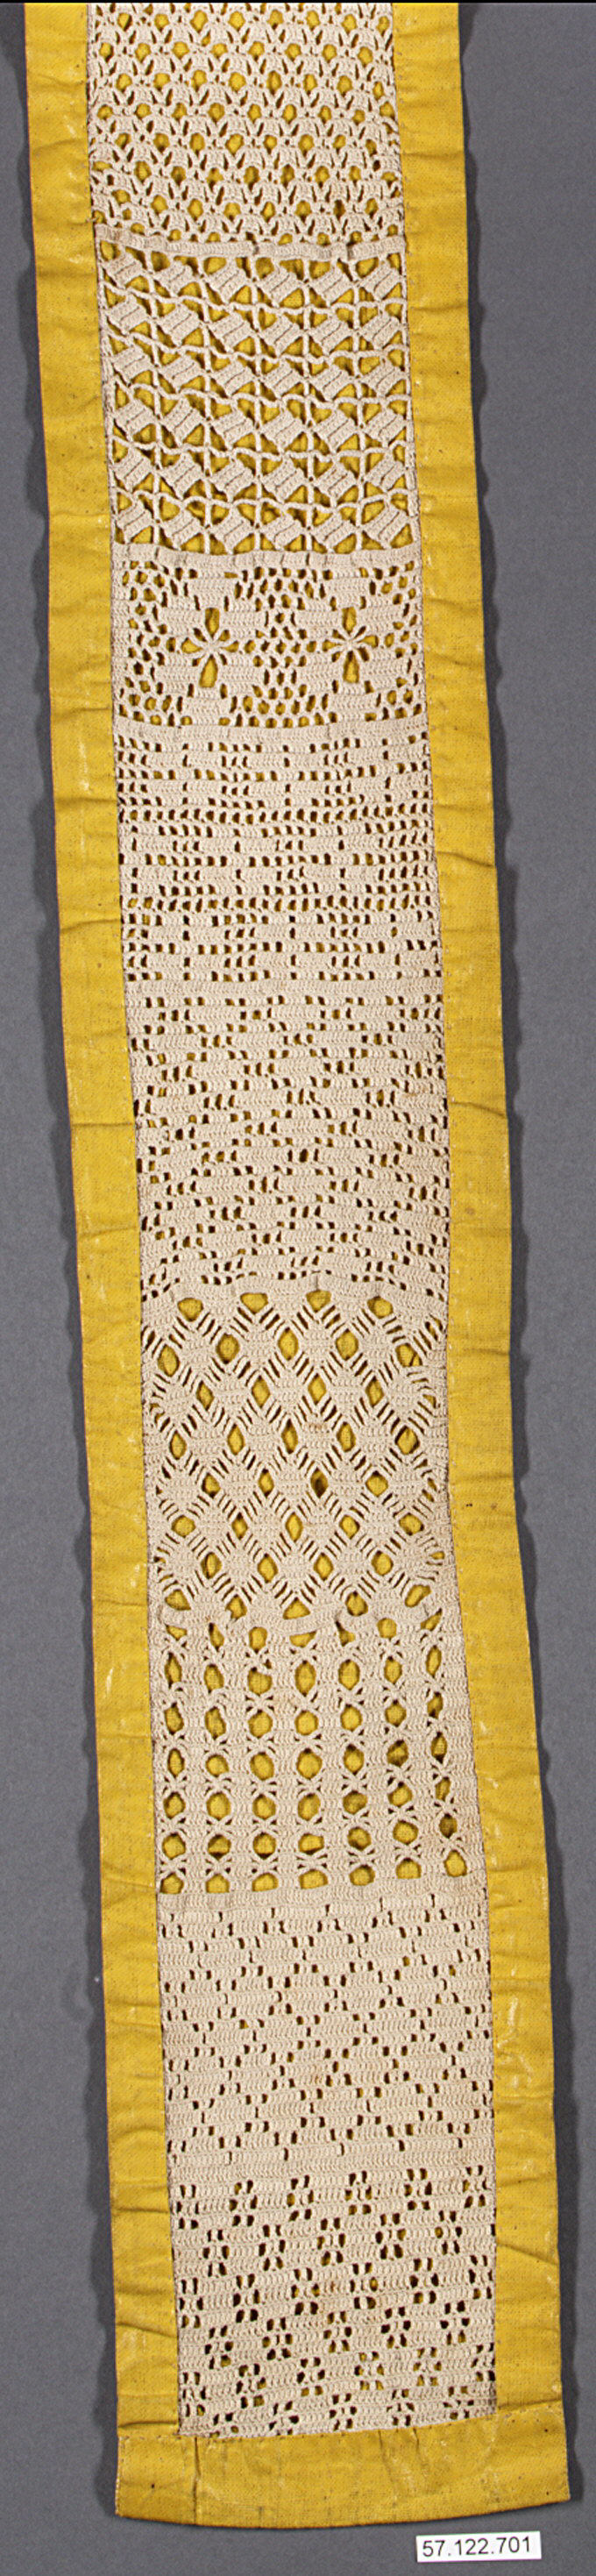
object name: sampler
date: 1801-1900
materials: linen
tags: flowers